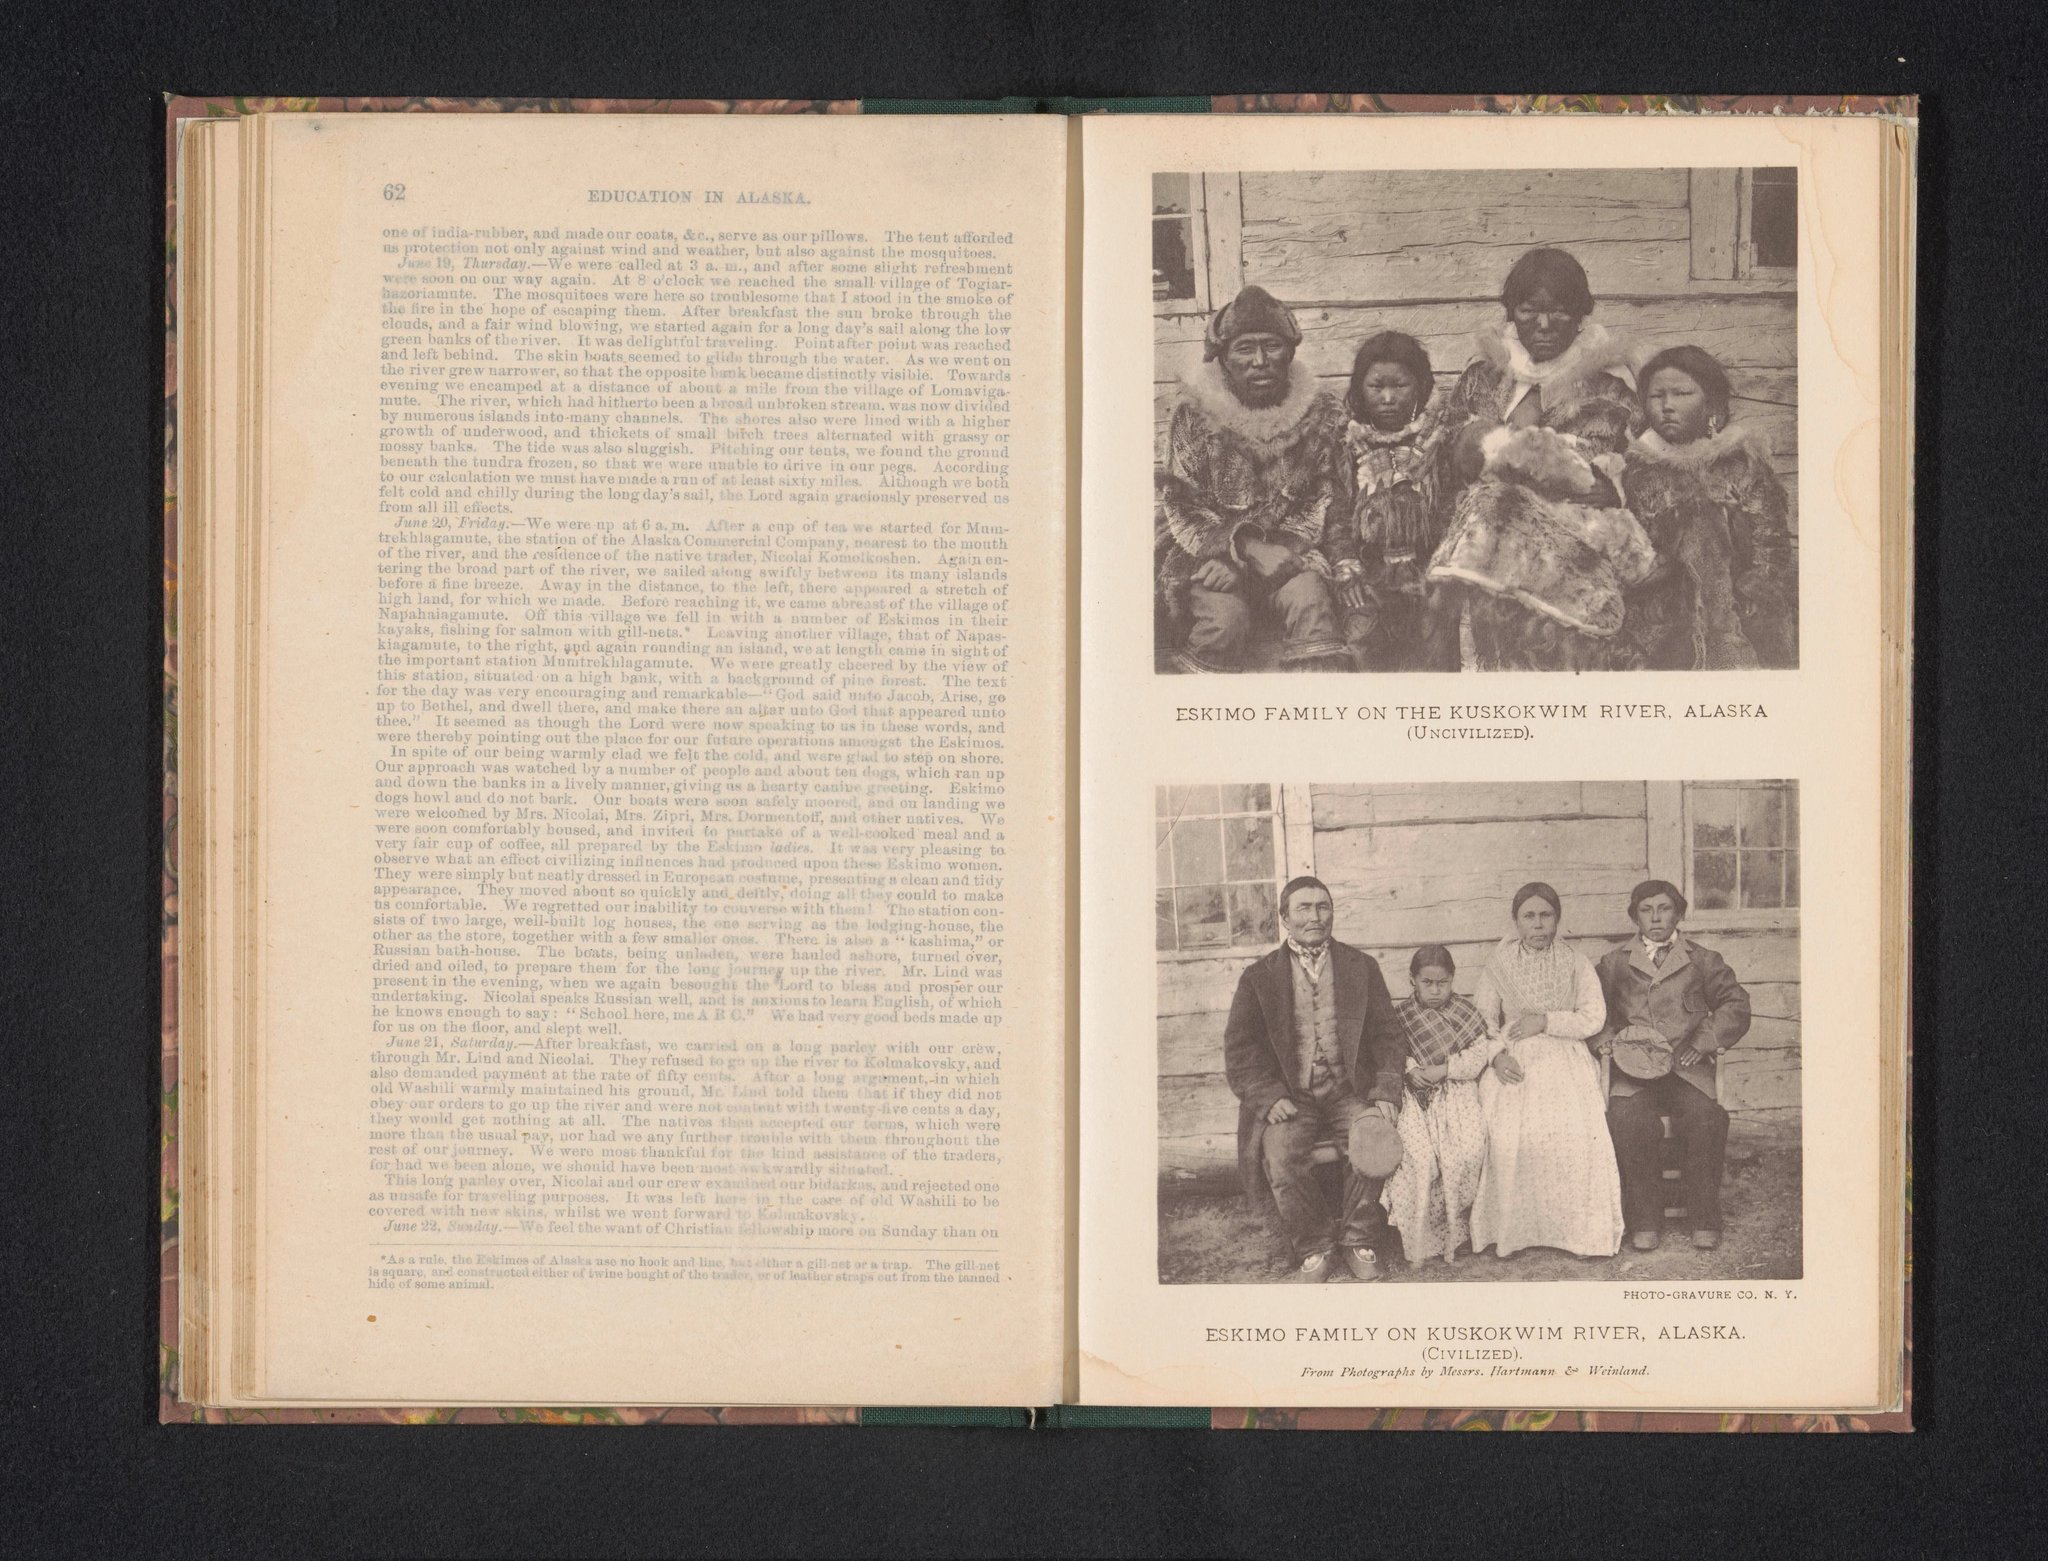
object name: photomechanical print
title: Eskimo family on the Kuskokwim River, Alaska (uncivilized)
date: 1881-1886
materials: paper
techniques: photograph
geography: alaska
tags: indigenous peoples of the arctic regions: inuit, anonymous historical persons portrayed in a group, in a group-portrait